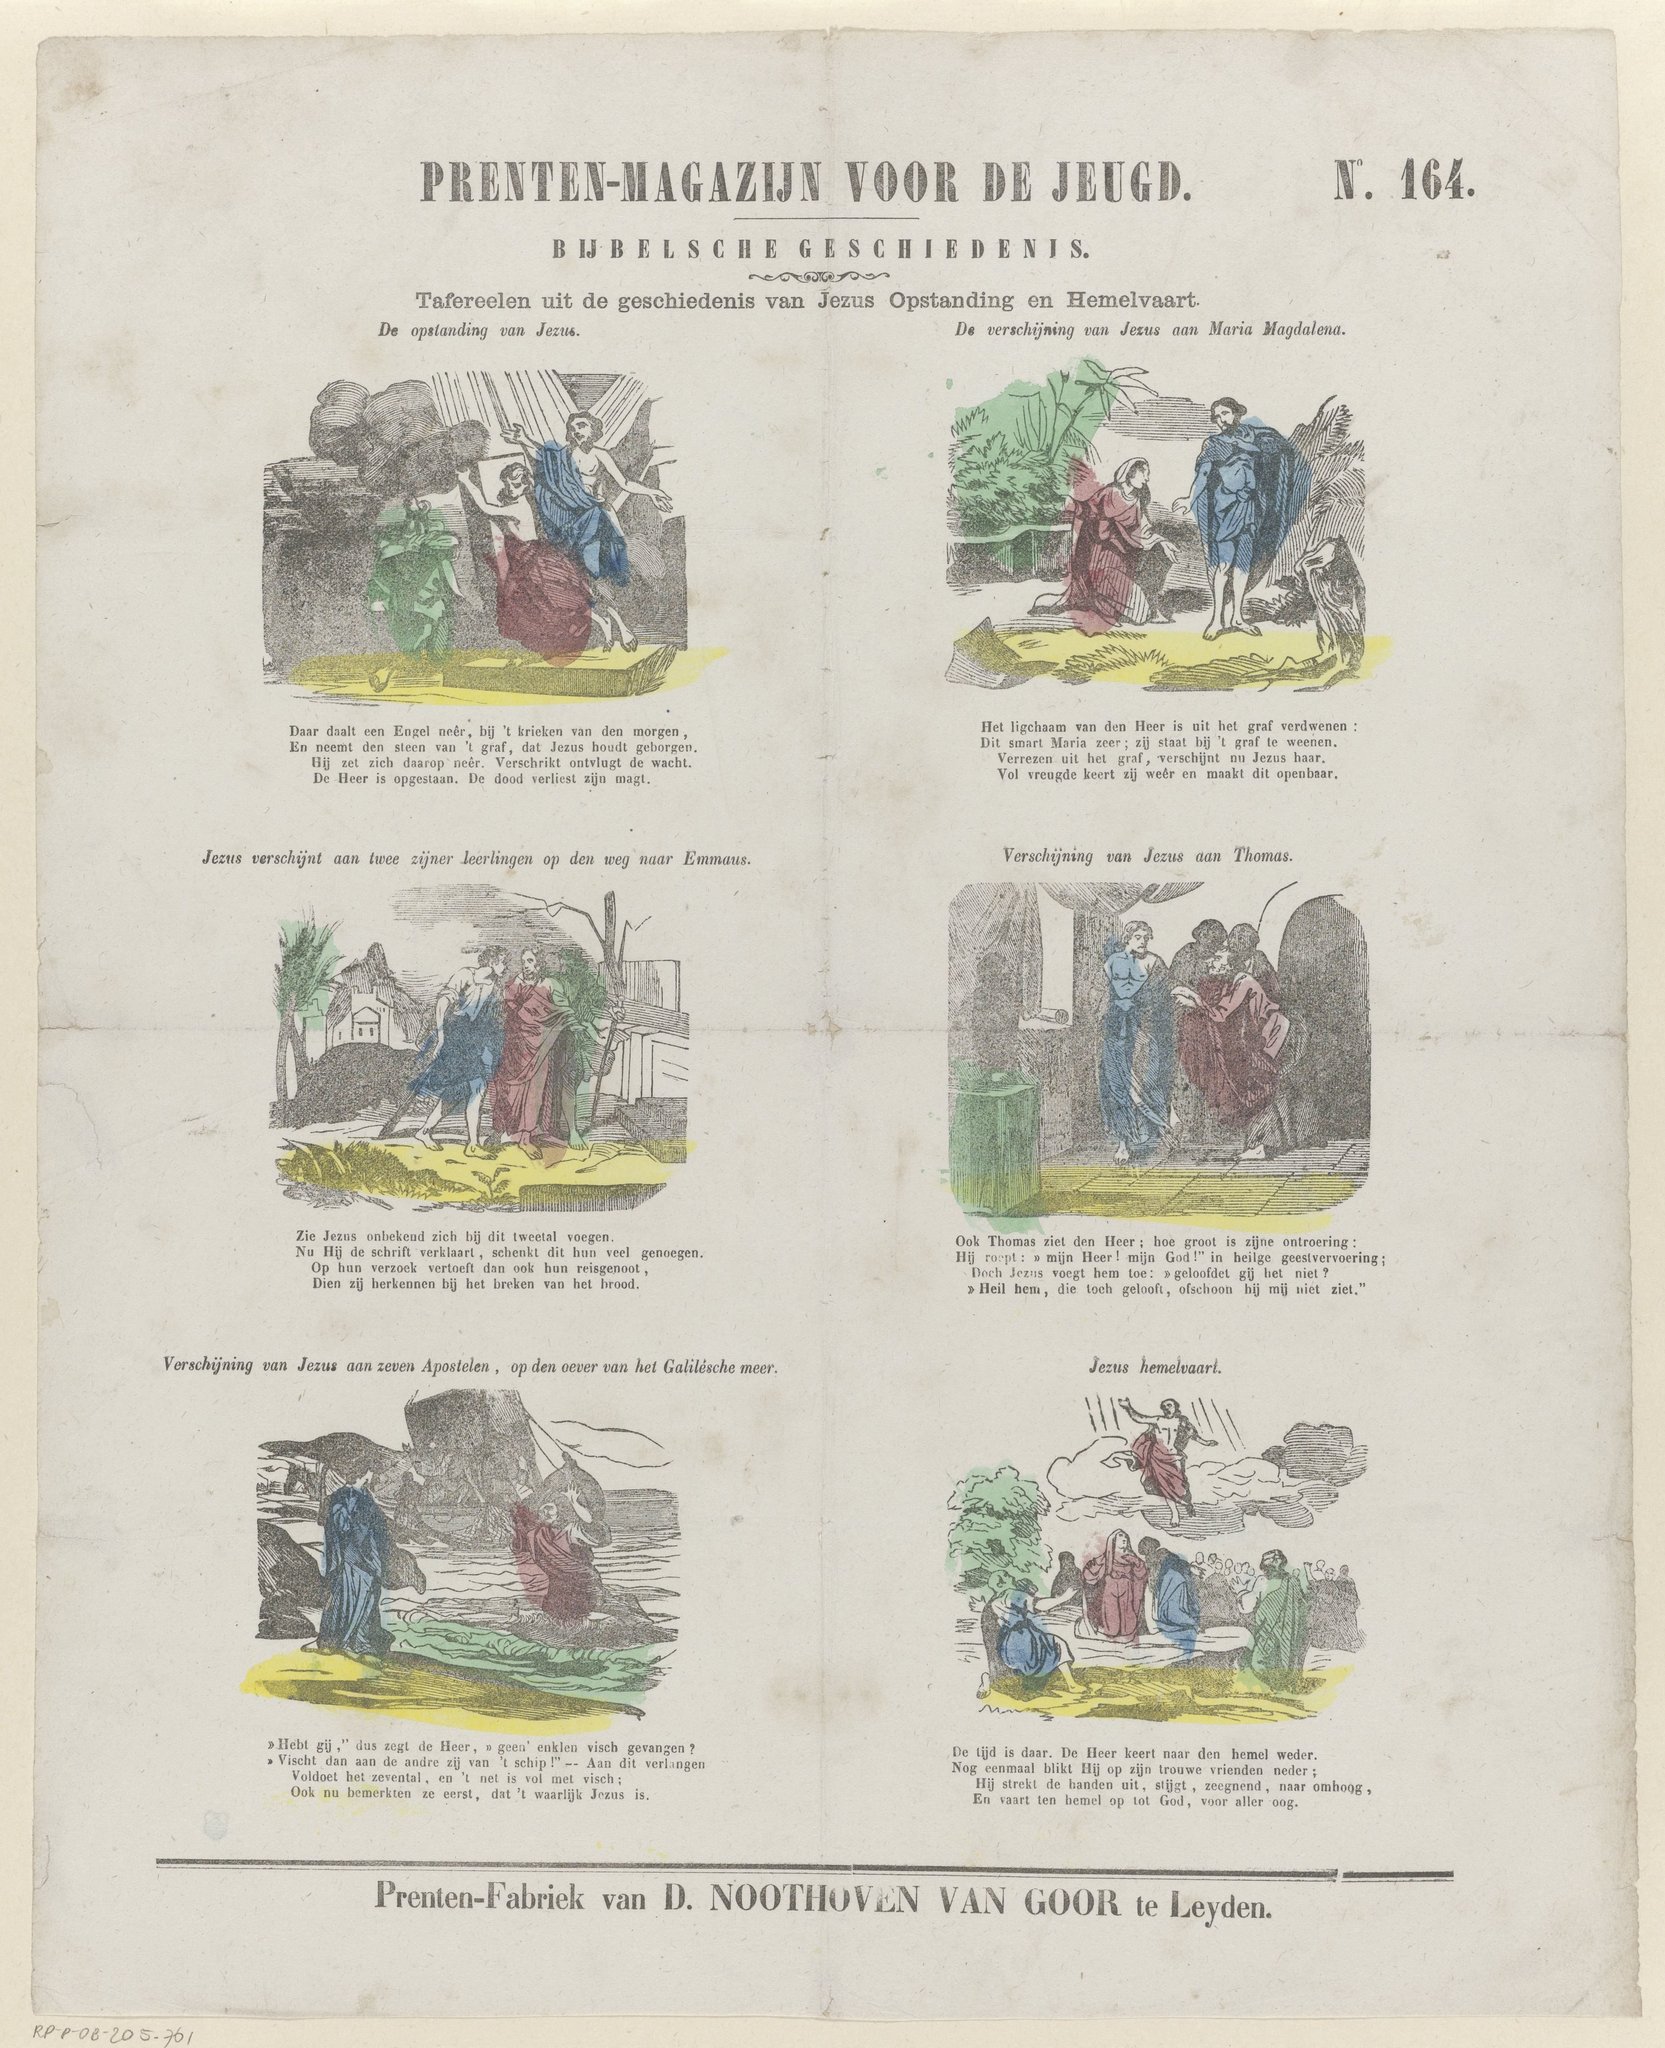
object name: popular print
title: Tafereelen uit de geschiedenis van Jezus opstanding en hemelvaart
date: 1850-1881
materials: paper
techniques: colour, letterpress printing, engraving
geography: netherlands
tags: (adult) christ appearing to mortals, resurrection of christ, appearances of christ after the resurrection, new testament, christ taken up by a cloud ~ ascension, series of scenes from the life of christ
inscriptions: collector's mark: Lugt 2760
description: Blad met 6 voorstellingen uit het leven van Christus. Boven elke voorstelling een titel en onder elke voorstelling een vierregelig vers. Genummerd rechtsboven: No. 164.